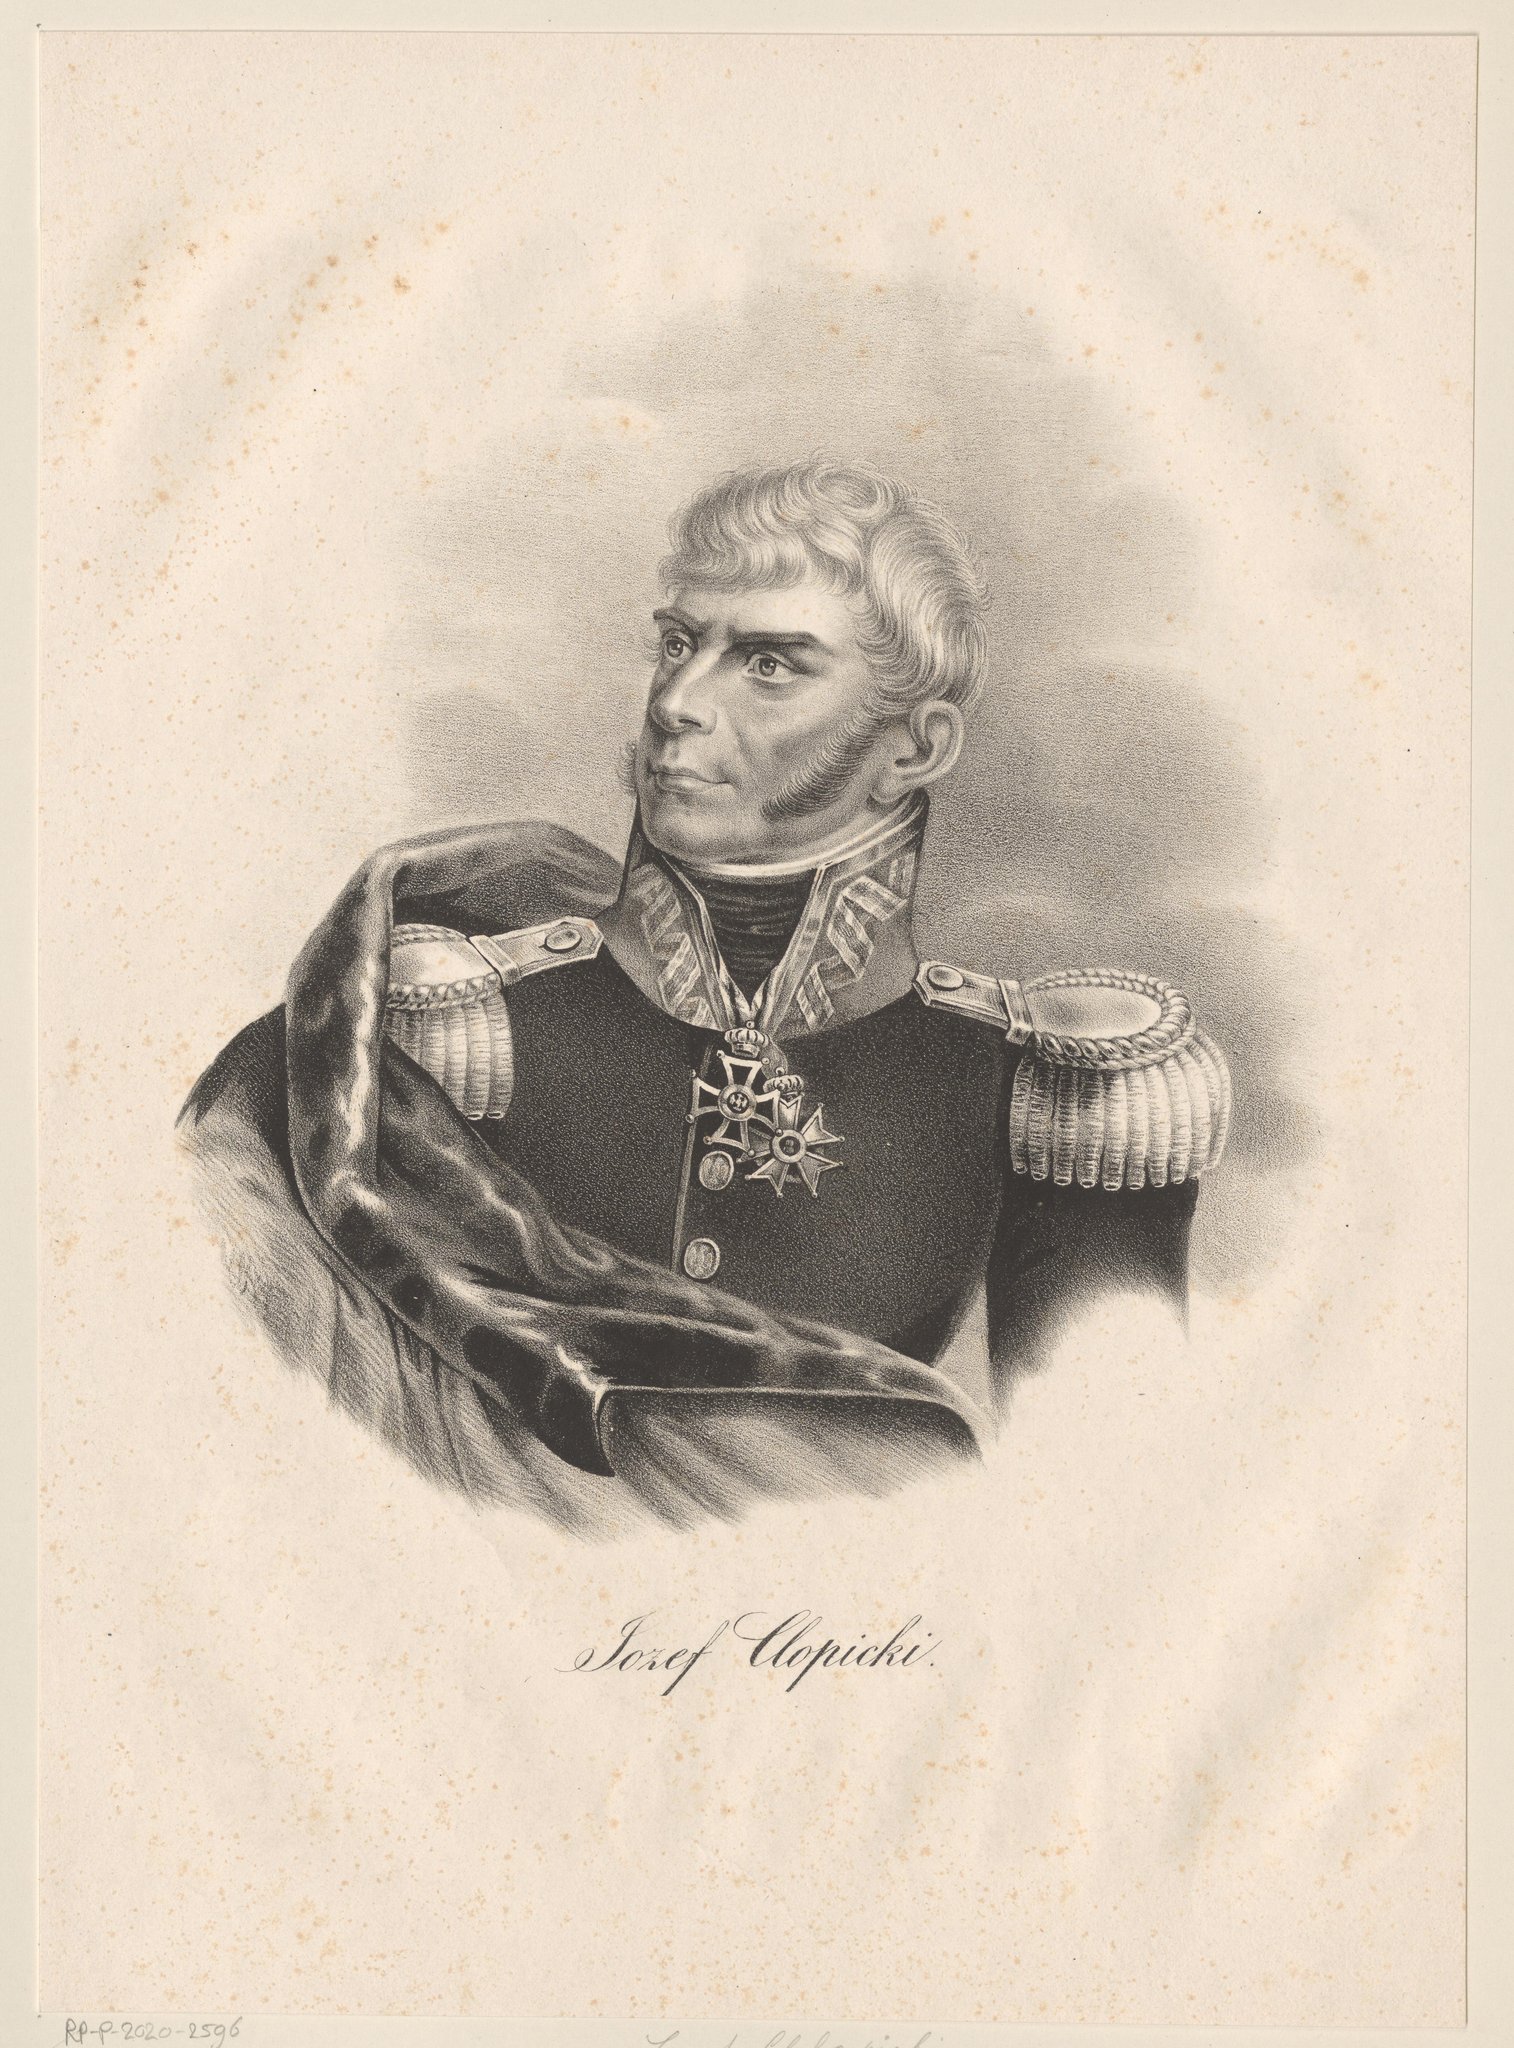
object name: print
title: Portret van Józef Chłopicki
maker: Anonymous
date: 1800-1899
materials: paper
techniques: lithograph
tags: historical persons